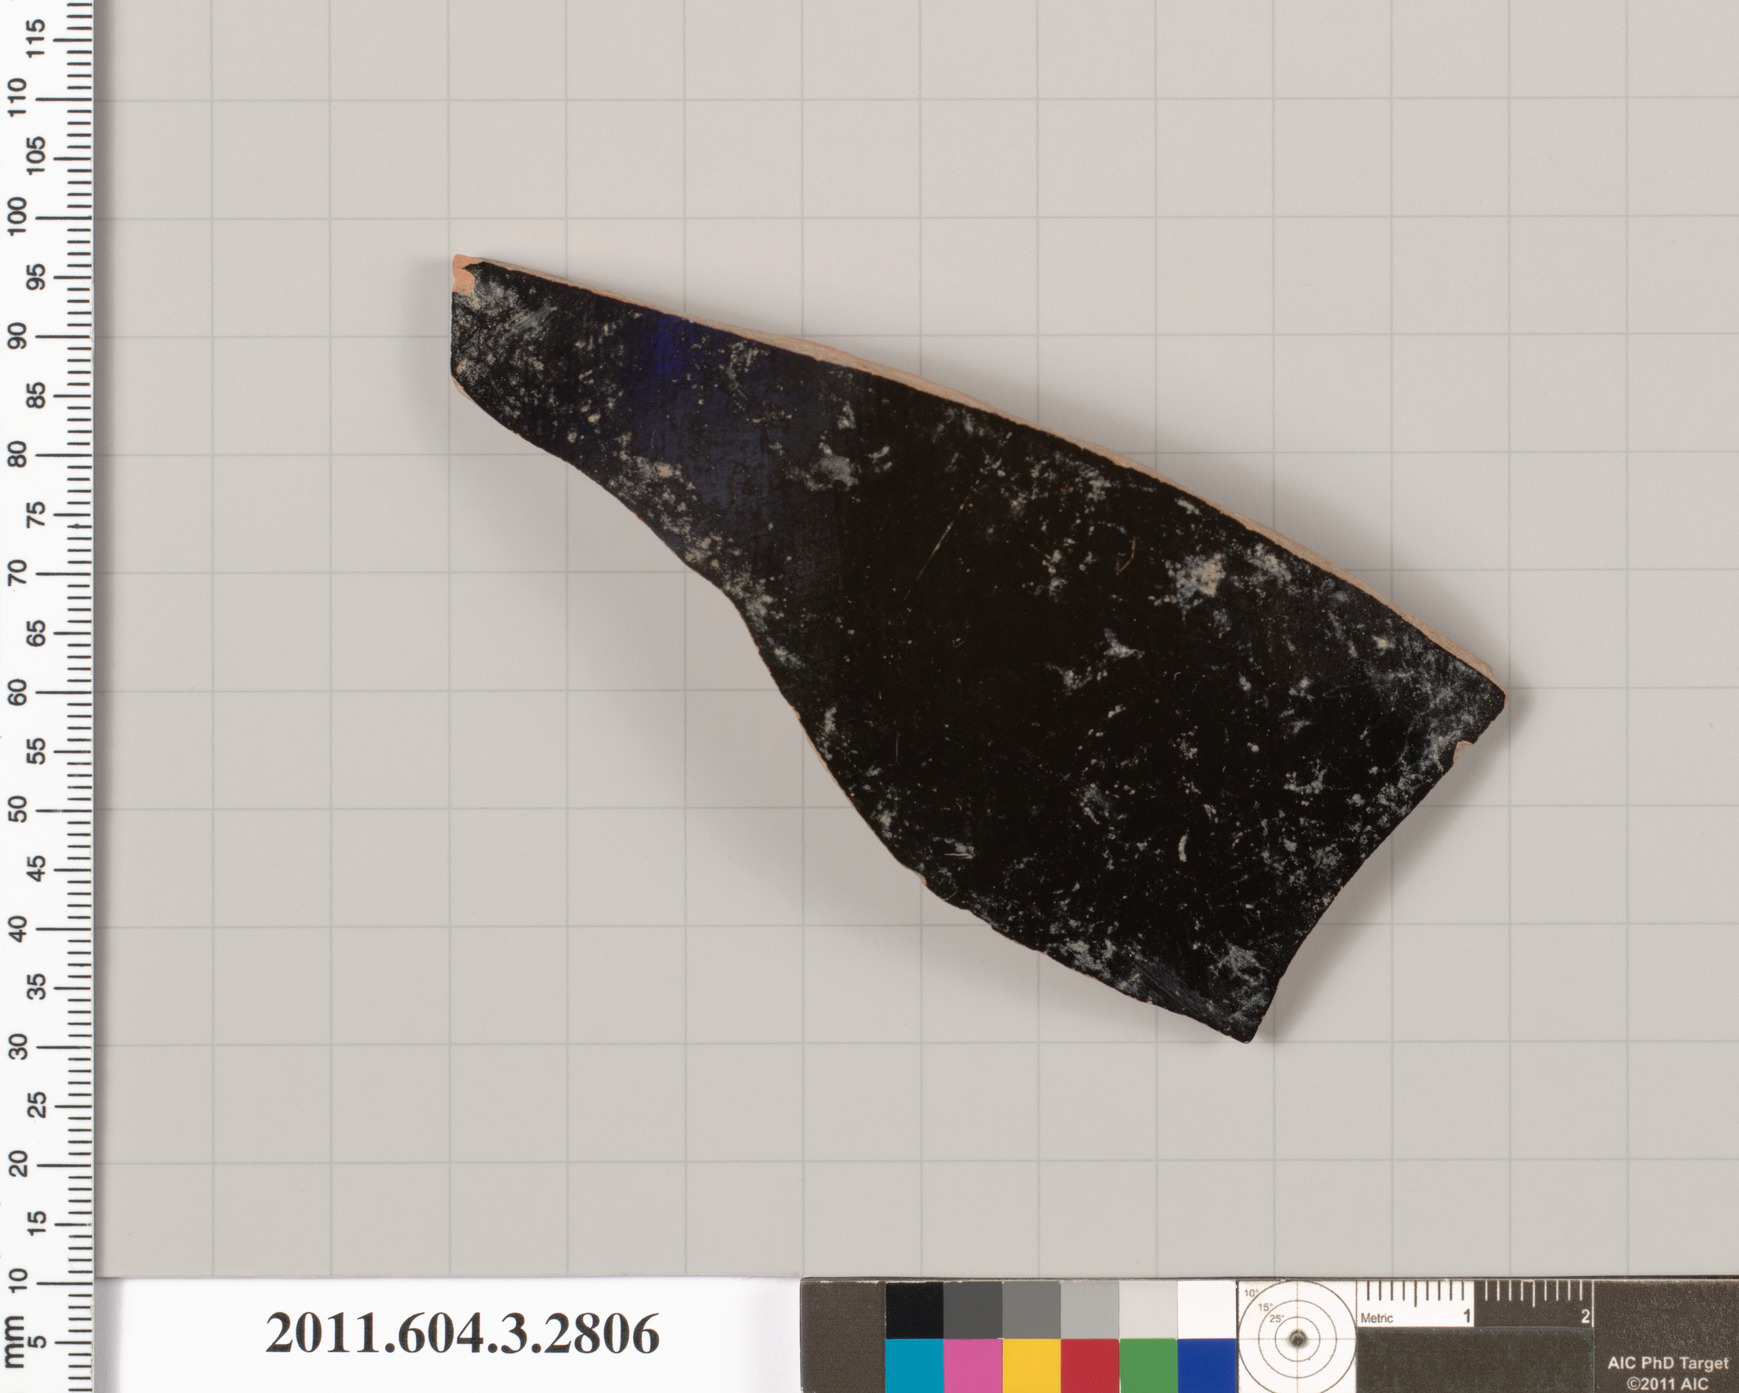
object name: oinochoe or olpe fragment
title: Terracotta fragment of an oinochoe (jug) or olpe (jug)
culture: greek, attic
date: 600-401 BCE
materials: terracotta